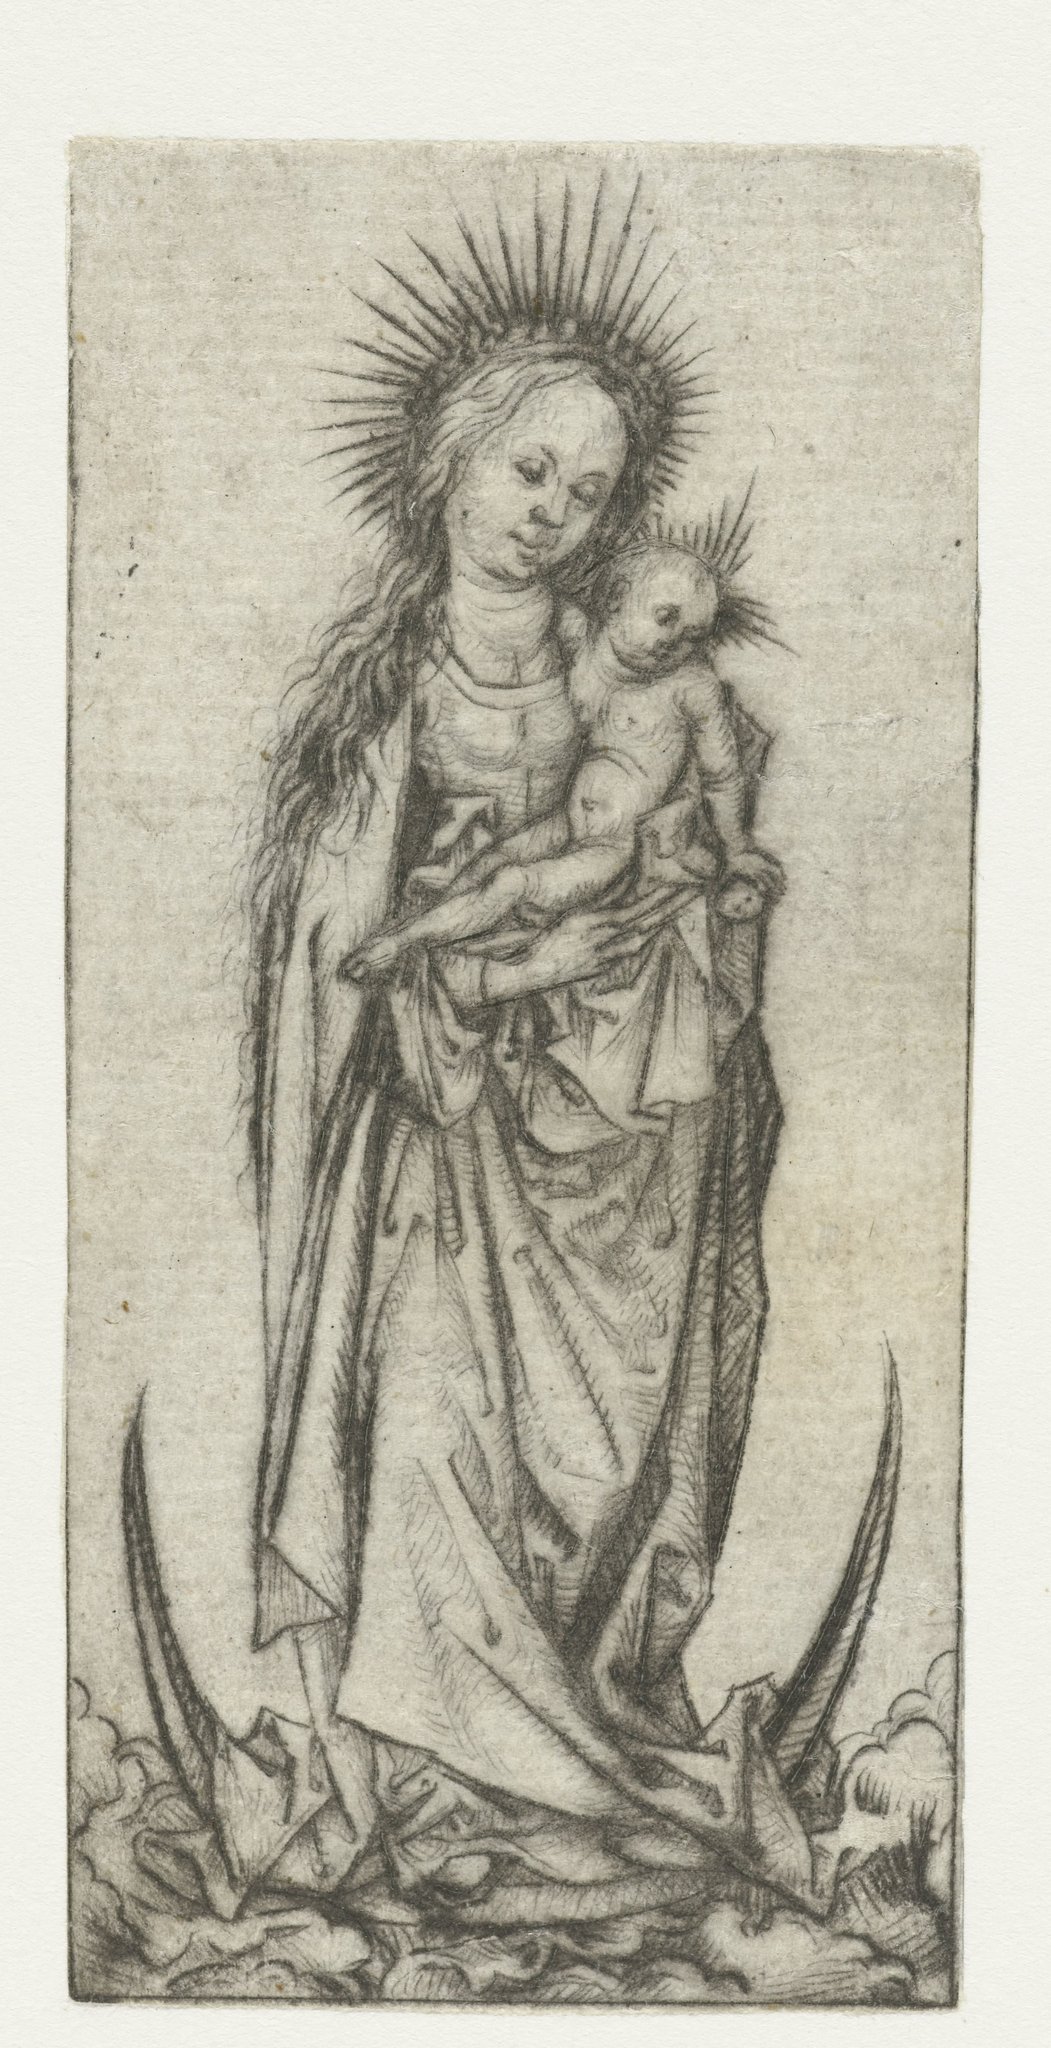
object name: print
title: Madonna op de maansikkel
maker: meester van het amsterdamse kabinet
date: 1478-1482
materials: paper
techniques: drypoint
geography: germany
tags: madonna on the crescent of the moon (sometimes called queen of heaven) (in mandorla)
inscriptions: collector's mark: Lugt 2228a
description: Maria met Kind, staand op de maansikkel.